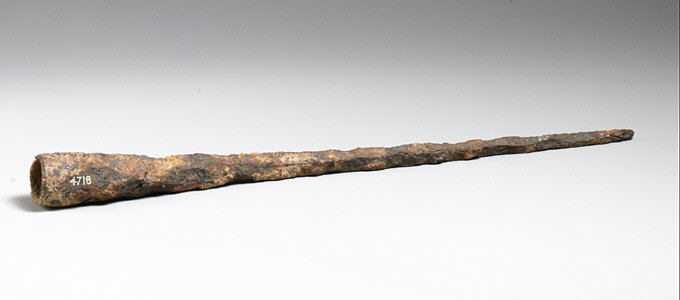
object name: spearhead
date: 7000 BCE-330 CE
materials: iron